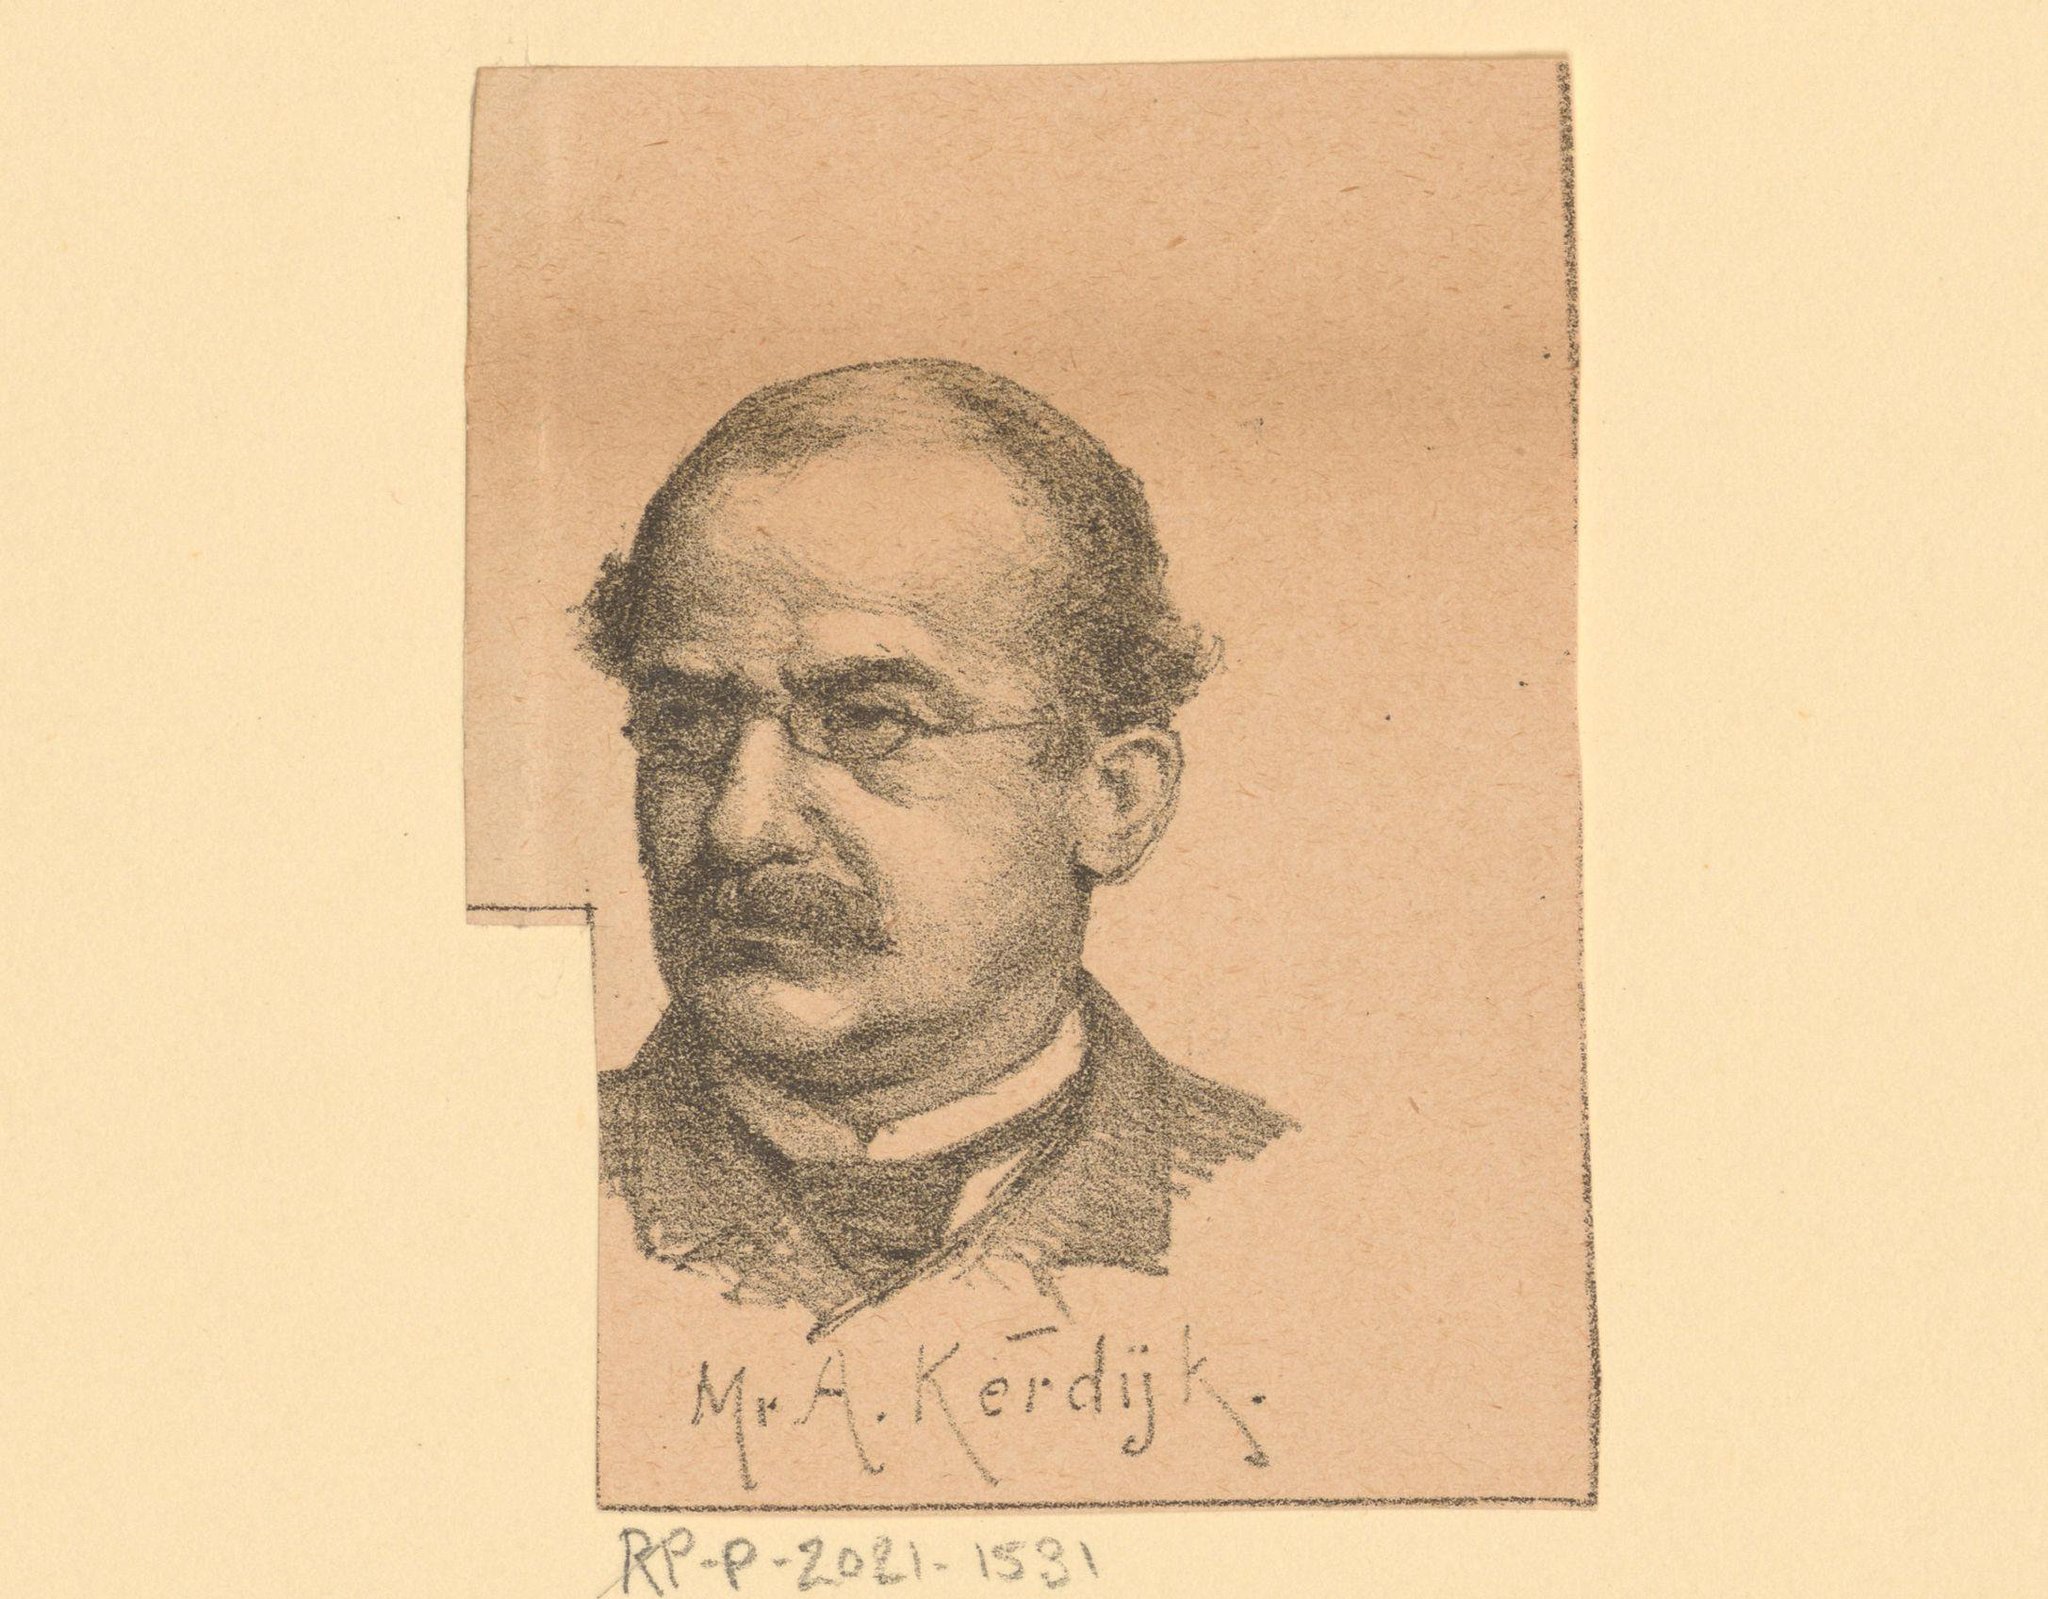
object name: print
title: Portret van Arnold Kerdijk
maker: Anonymous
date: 1856-1915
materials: paper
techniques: lithograph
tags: politician, historical persons